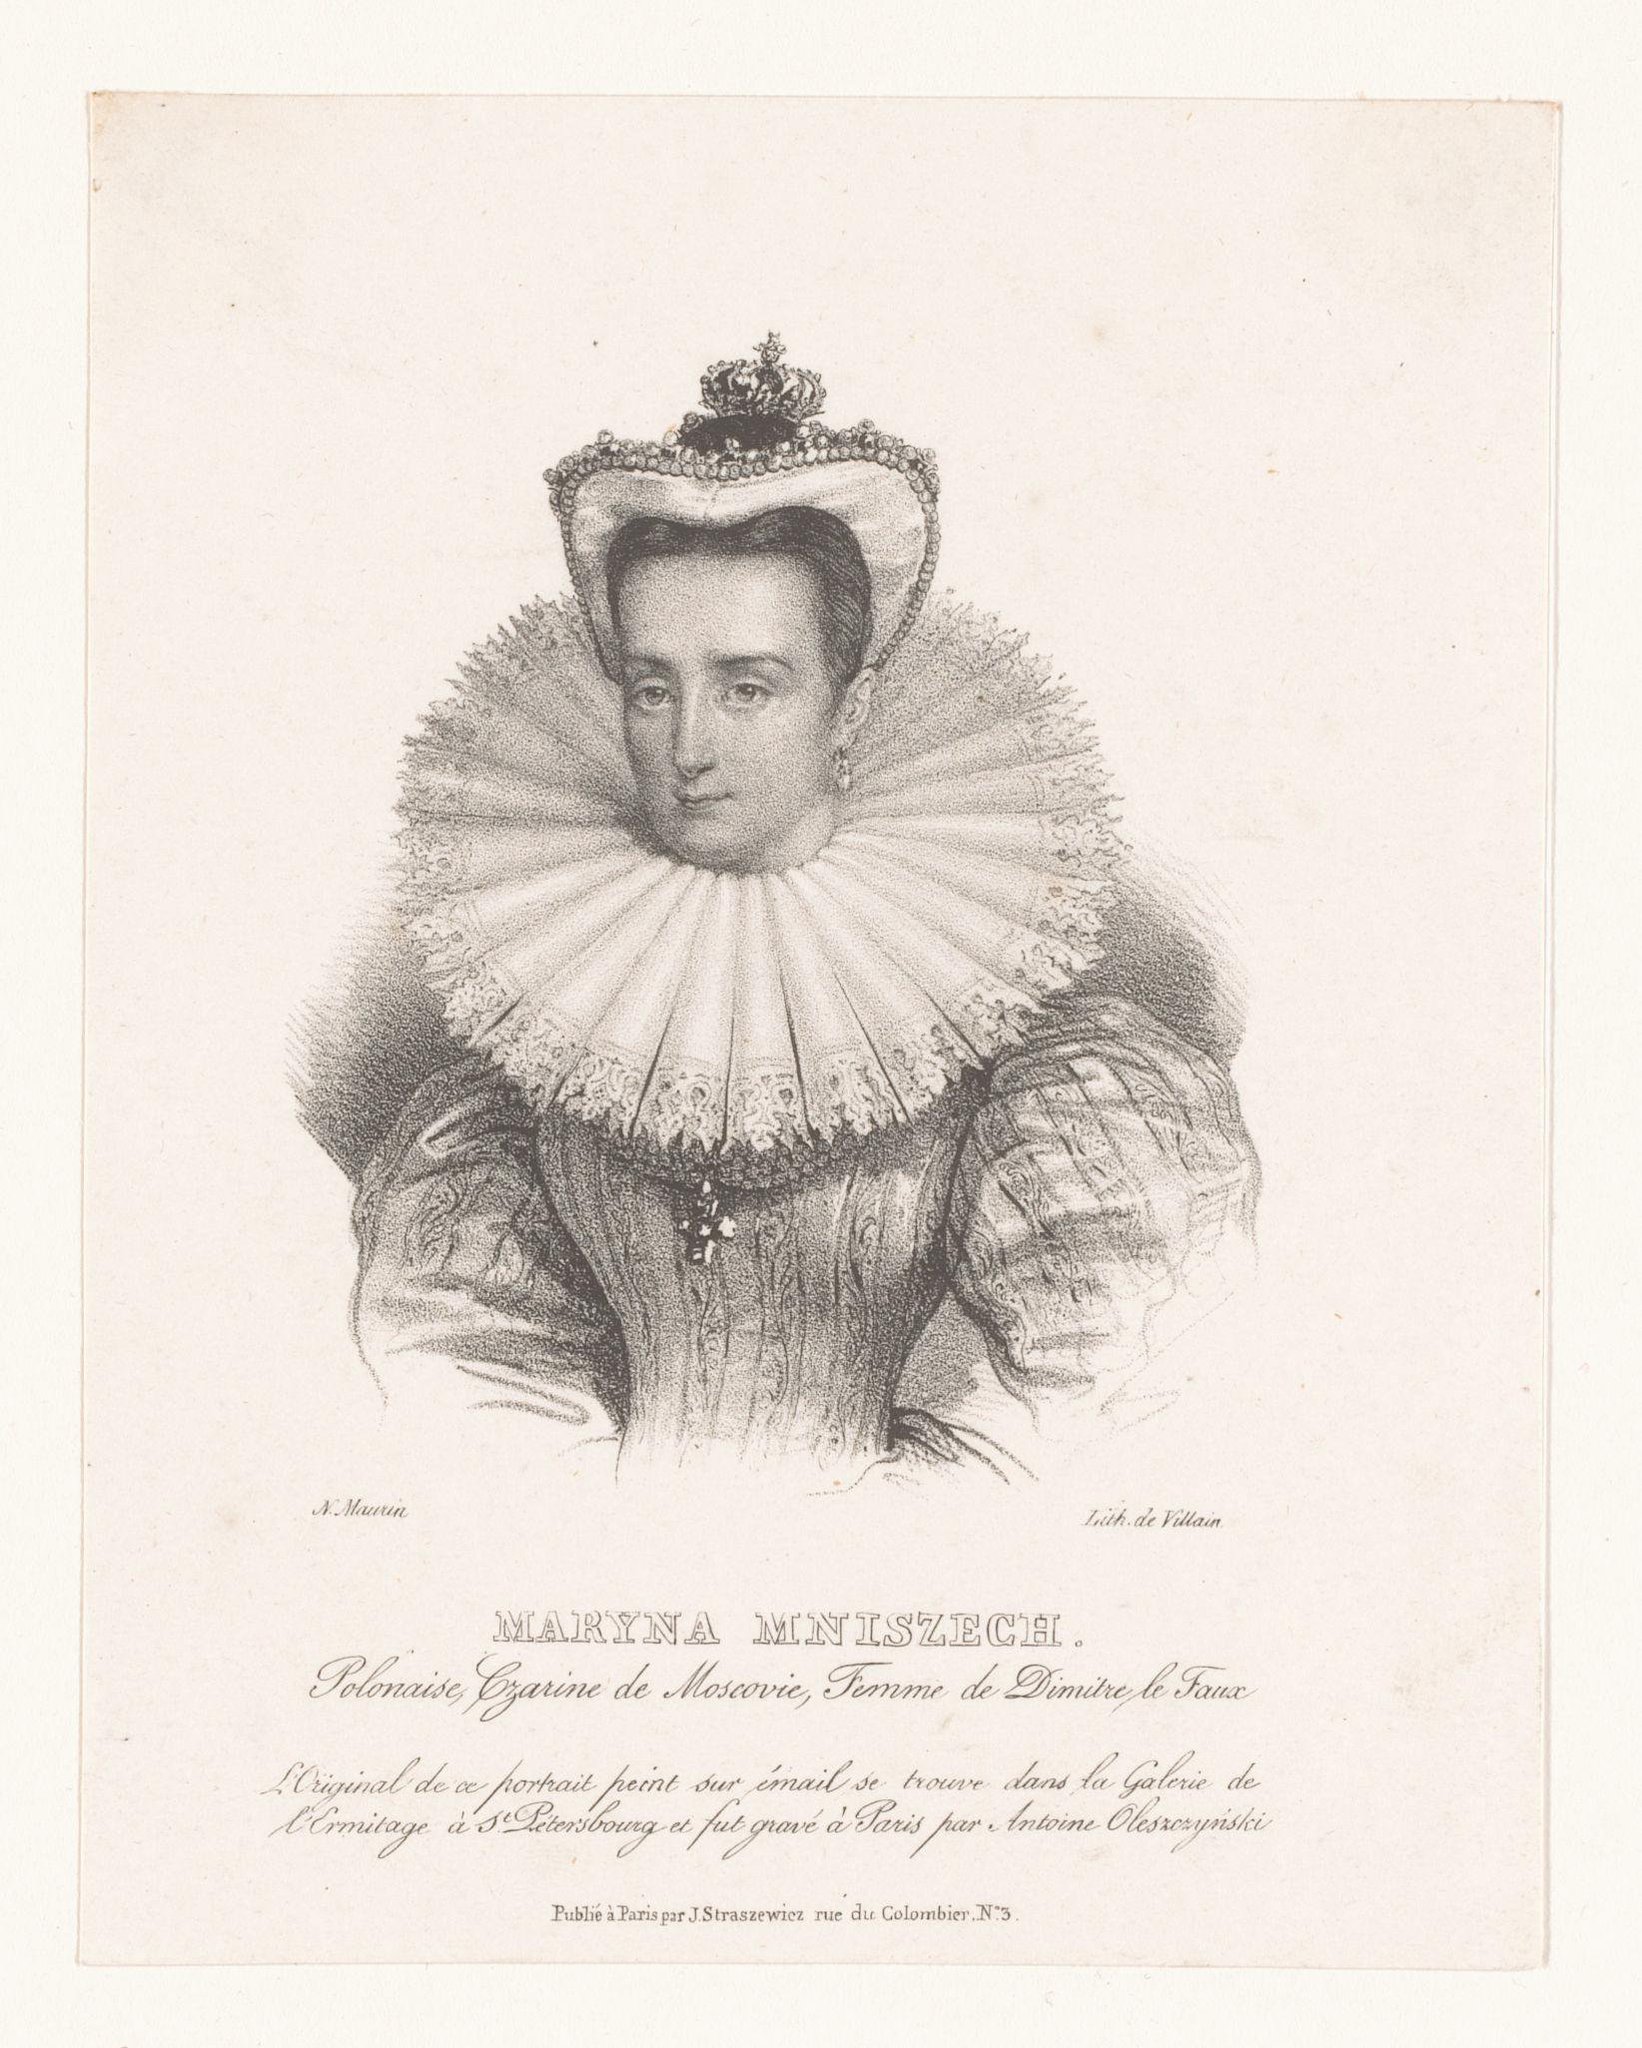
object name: print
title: Maryna Mniszech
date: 1826-1838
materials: paper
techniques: lithograph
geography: paris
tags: historical persons, emperor - bb - female ruler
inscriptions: collector's mark: Lugt 2228